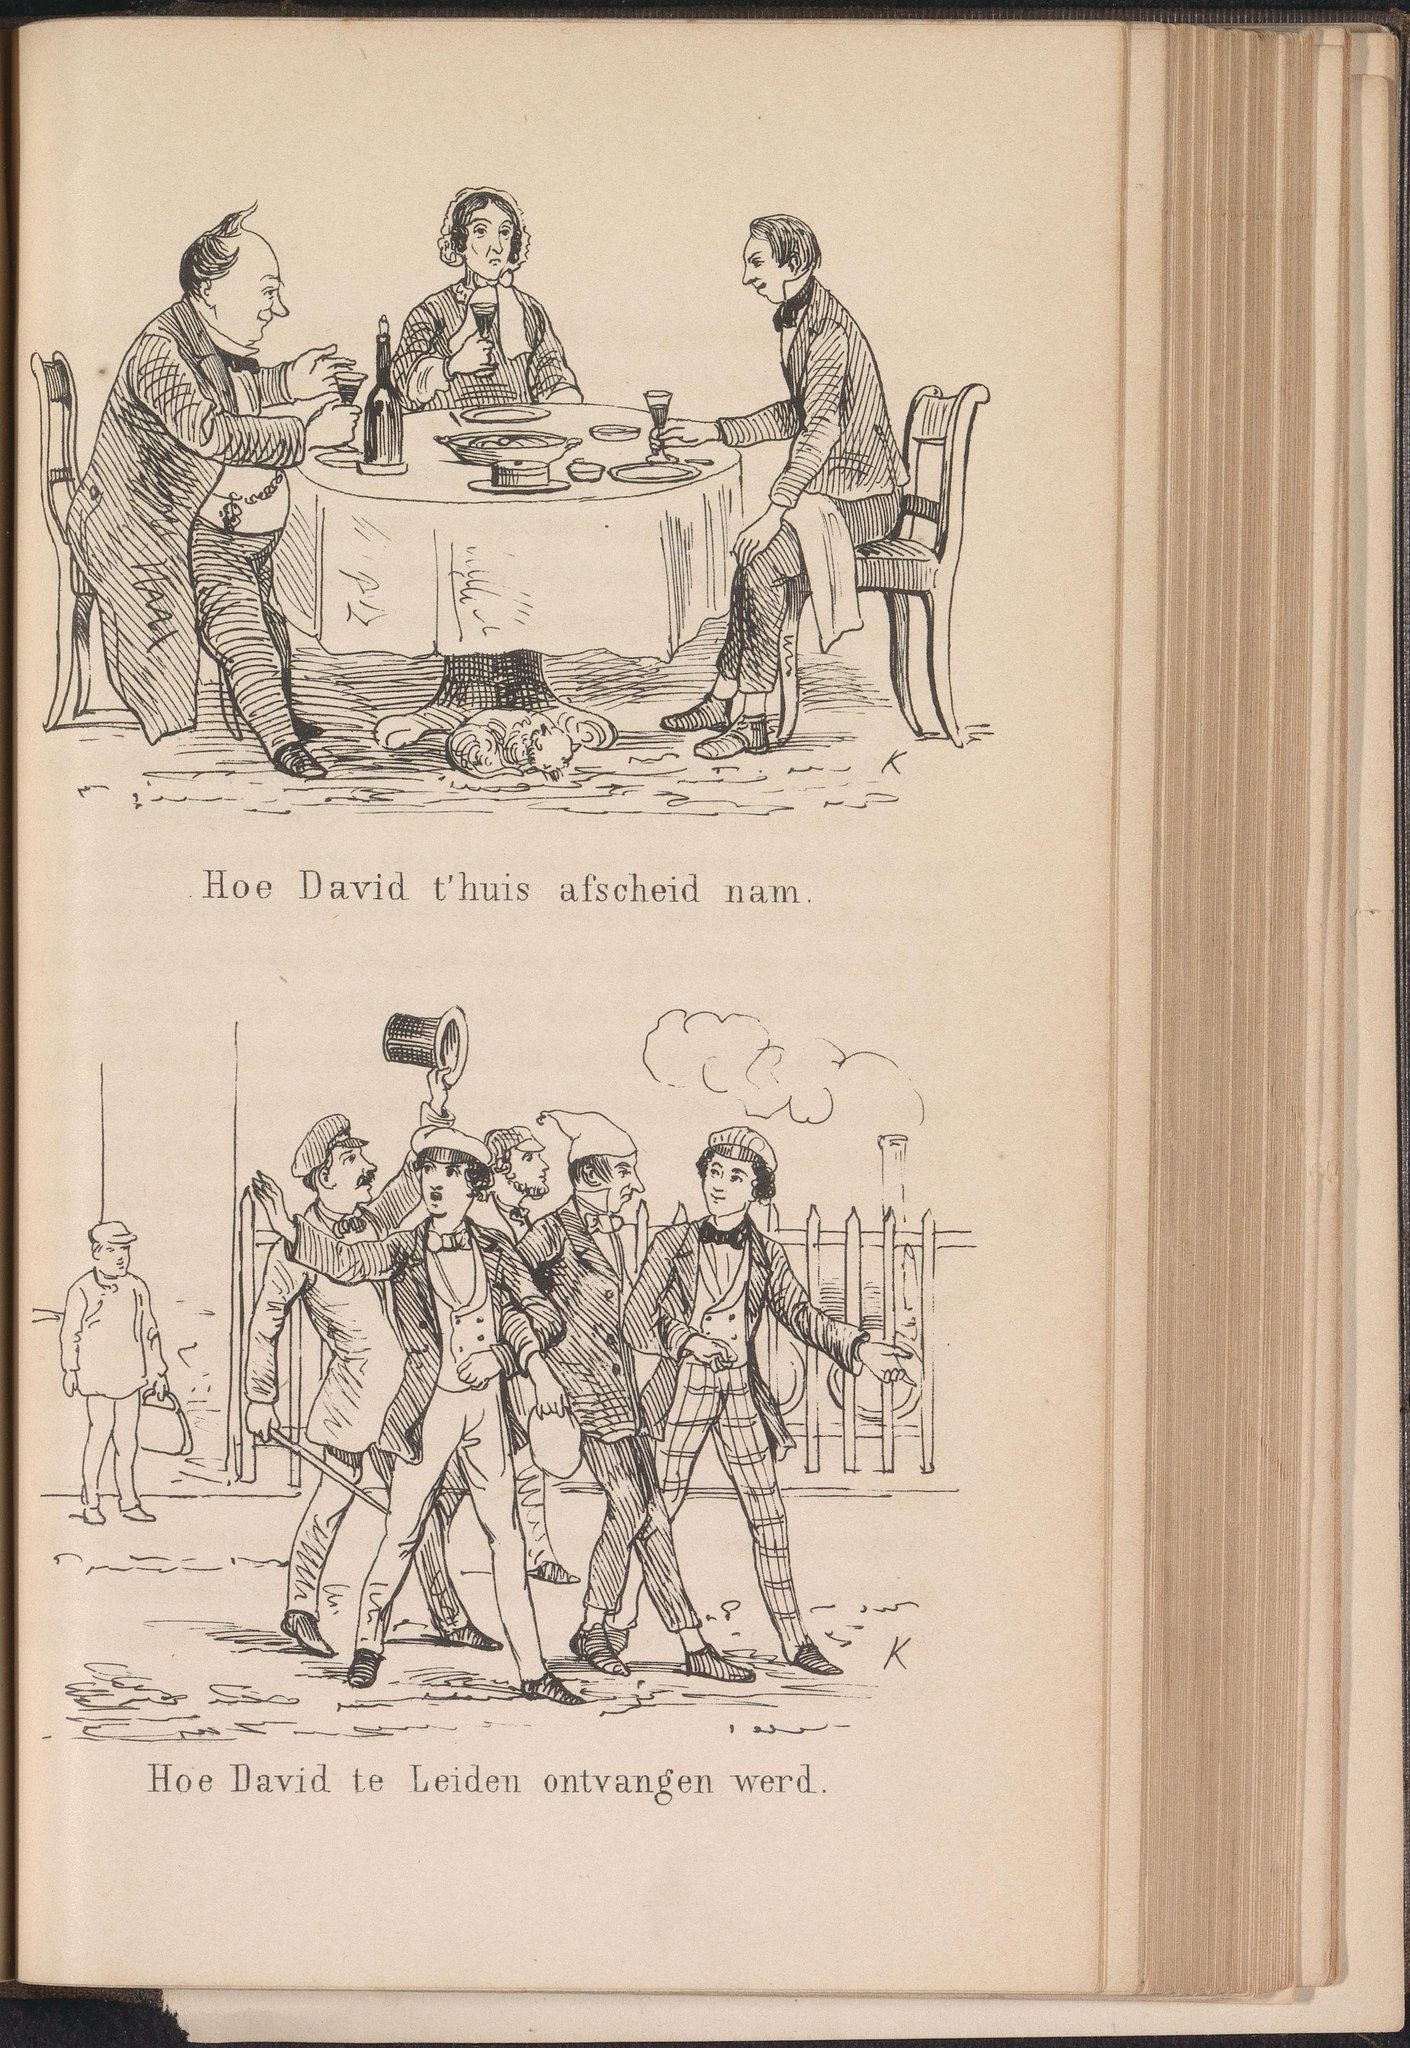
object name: book illustration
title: Illustraties bij het verhaal 'Lotgevallen en Ontmoetingen van David Harthals', in de Leidse studentenalmanak, 1859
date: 1859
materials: paper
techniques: lithograph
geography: netherlands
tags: student life, leiden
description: Blad met twee illustraties bij het verhaal 'Lotgevallen en Ontmoetingen van David Harthals'. Spotprent in de studentenalmanak van de Universiteit van Leiden van het jaar 1859.